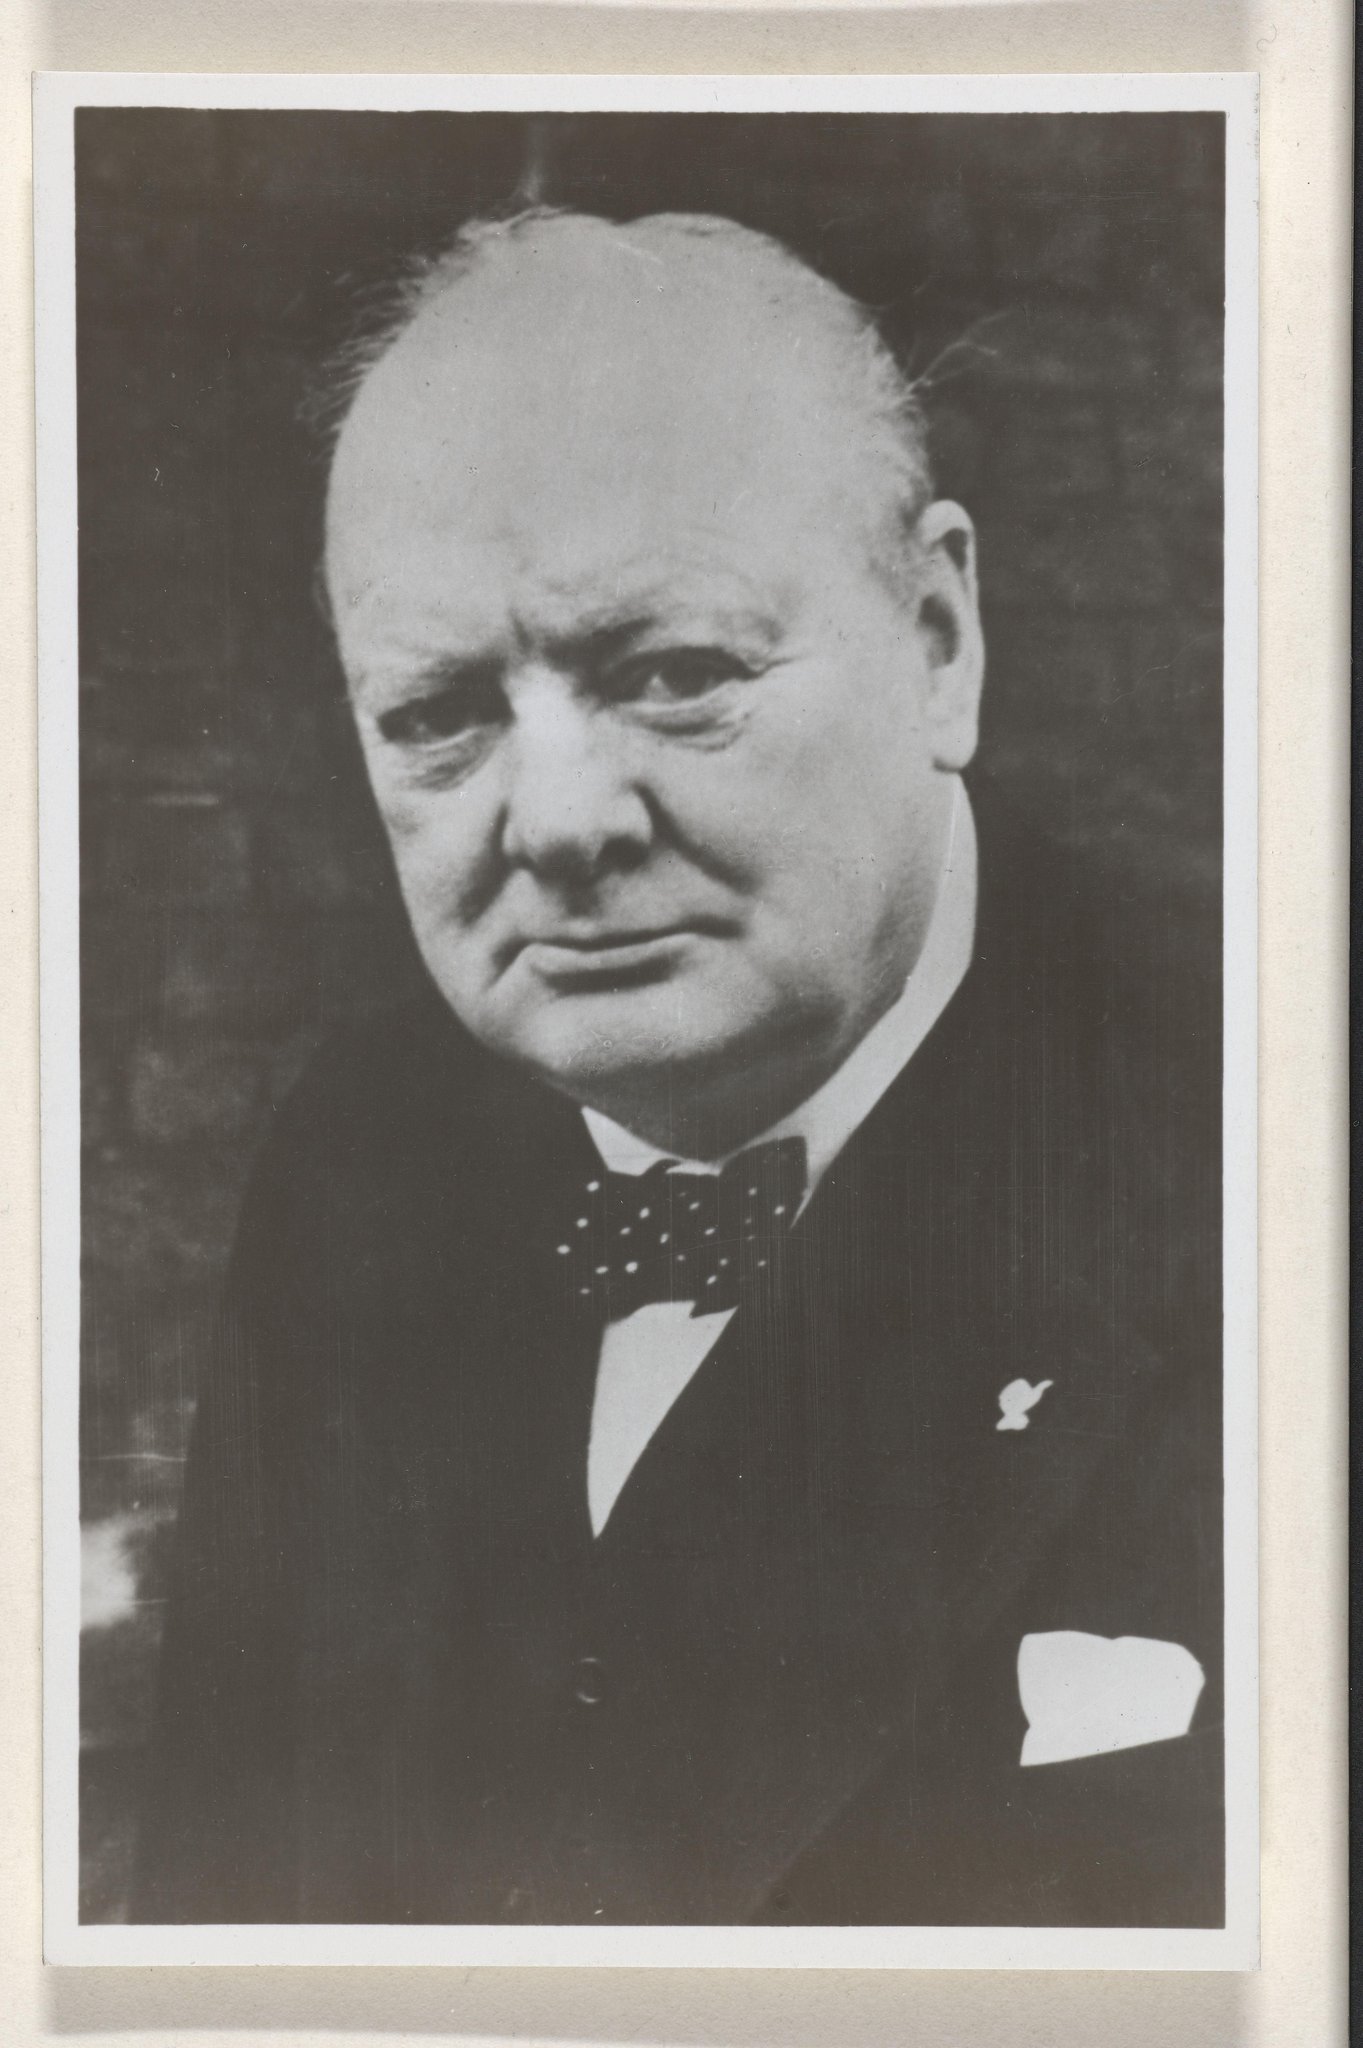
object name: photograph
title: Winston S. Churchill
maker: Anonymous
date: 1940-1963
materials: photographic support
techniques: gelatin silver print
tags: historical persons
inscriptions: stamp: ‘Archief 1940-1945 Joh. Schaede v. Baerlestraat 64-, Amsterdam’